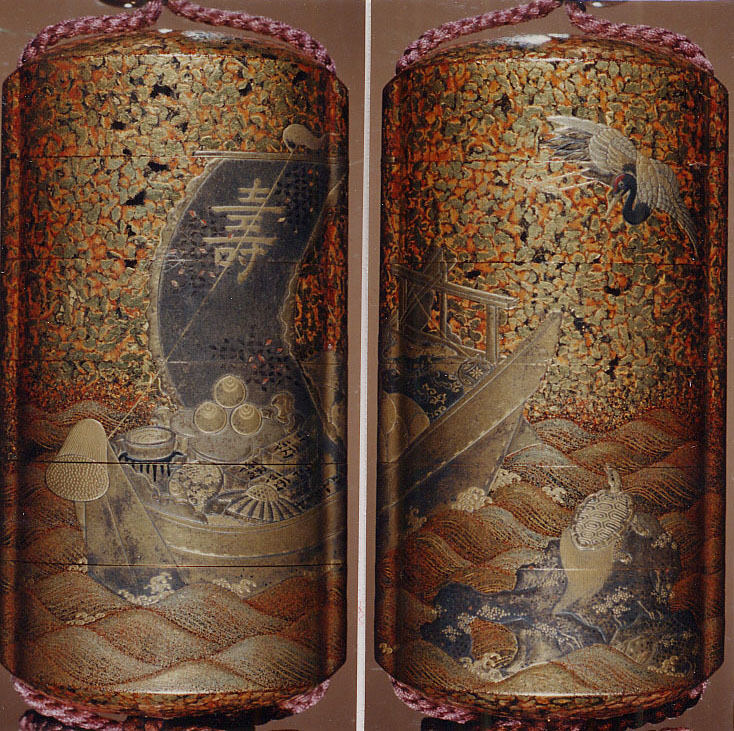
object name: inrō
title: Case (Inrō) with Design of Treasure Boat on Waves (obverse); Crane in Flight and Tortoise on Rocks (reverse)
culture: japanese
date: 1701-1900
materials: gold, lacquer, silver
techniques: fundame, hiramakie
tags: cranes,turtles,waves,boats